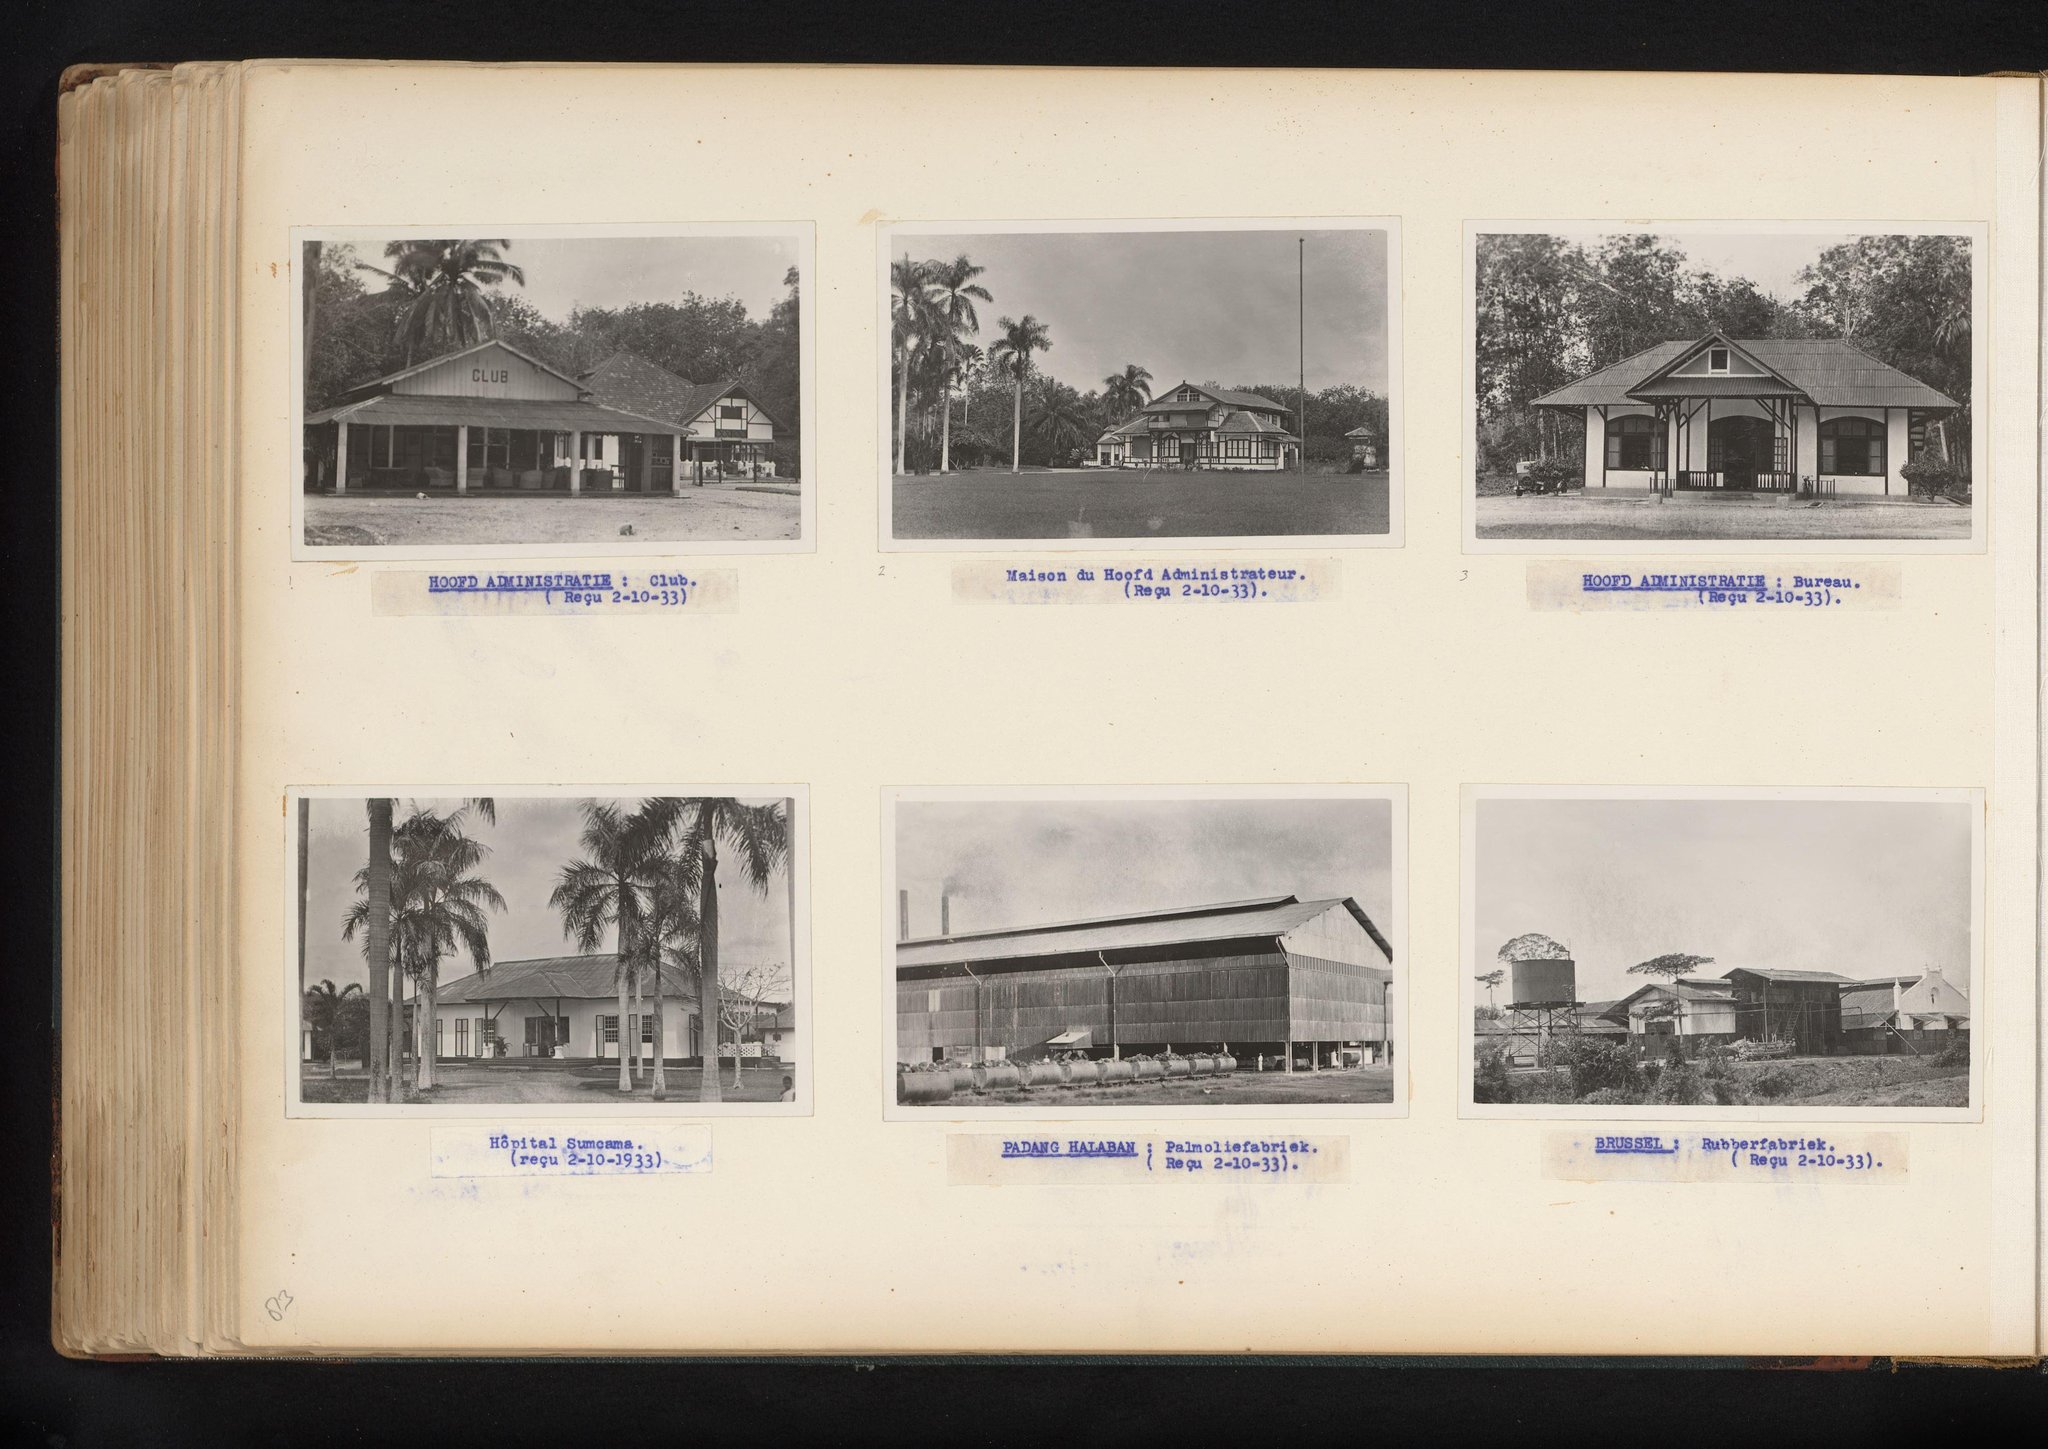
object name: photograph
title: Bedrijfsgebouwen, 1933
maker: Anonymous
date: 1933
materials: cardboard, photographic support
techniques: gelatin silver print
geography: sumatra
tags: plantation, (non-fruit) products of plants or trees: rubber, (non-fruit) products of plants or trees: palm oil, hospital, sumatra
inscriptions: inscription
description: Blad met zes foto's van bedrijfs- en administratiegebouwen op Pernantian, Padang Halaban en Brussel, 1933. Met etiketten met onderschriften onder de foto's. Onderdeel van het fotoalbum over de plantages Brussel en Pernantian van de Sumatra Caoutchouc Maatschappij op de Oostkust van Sumatra in de jaren 1910-1935.